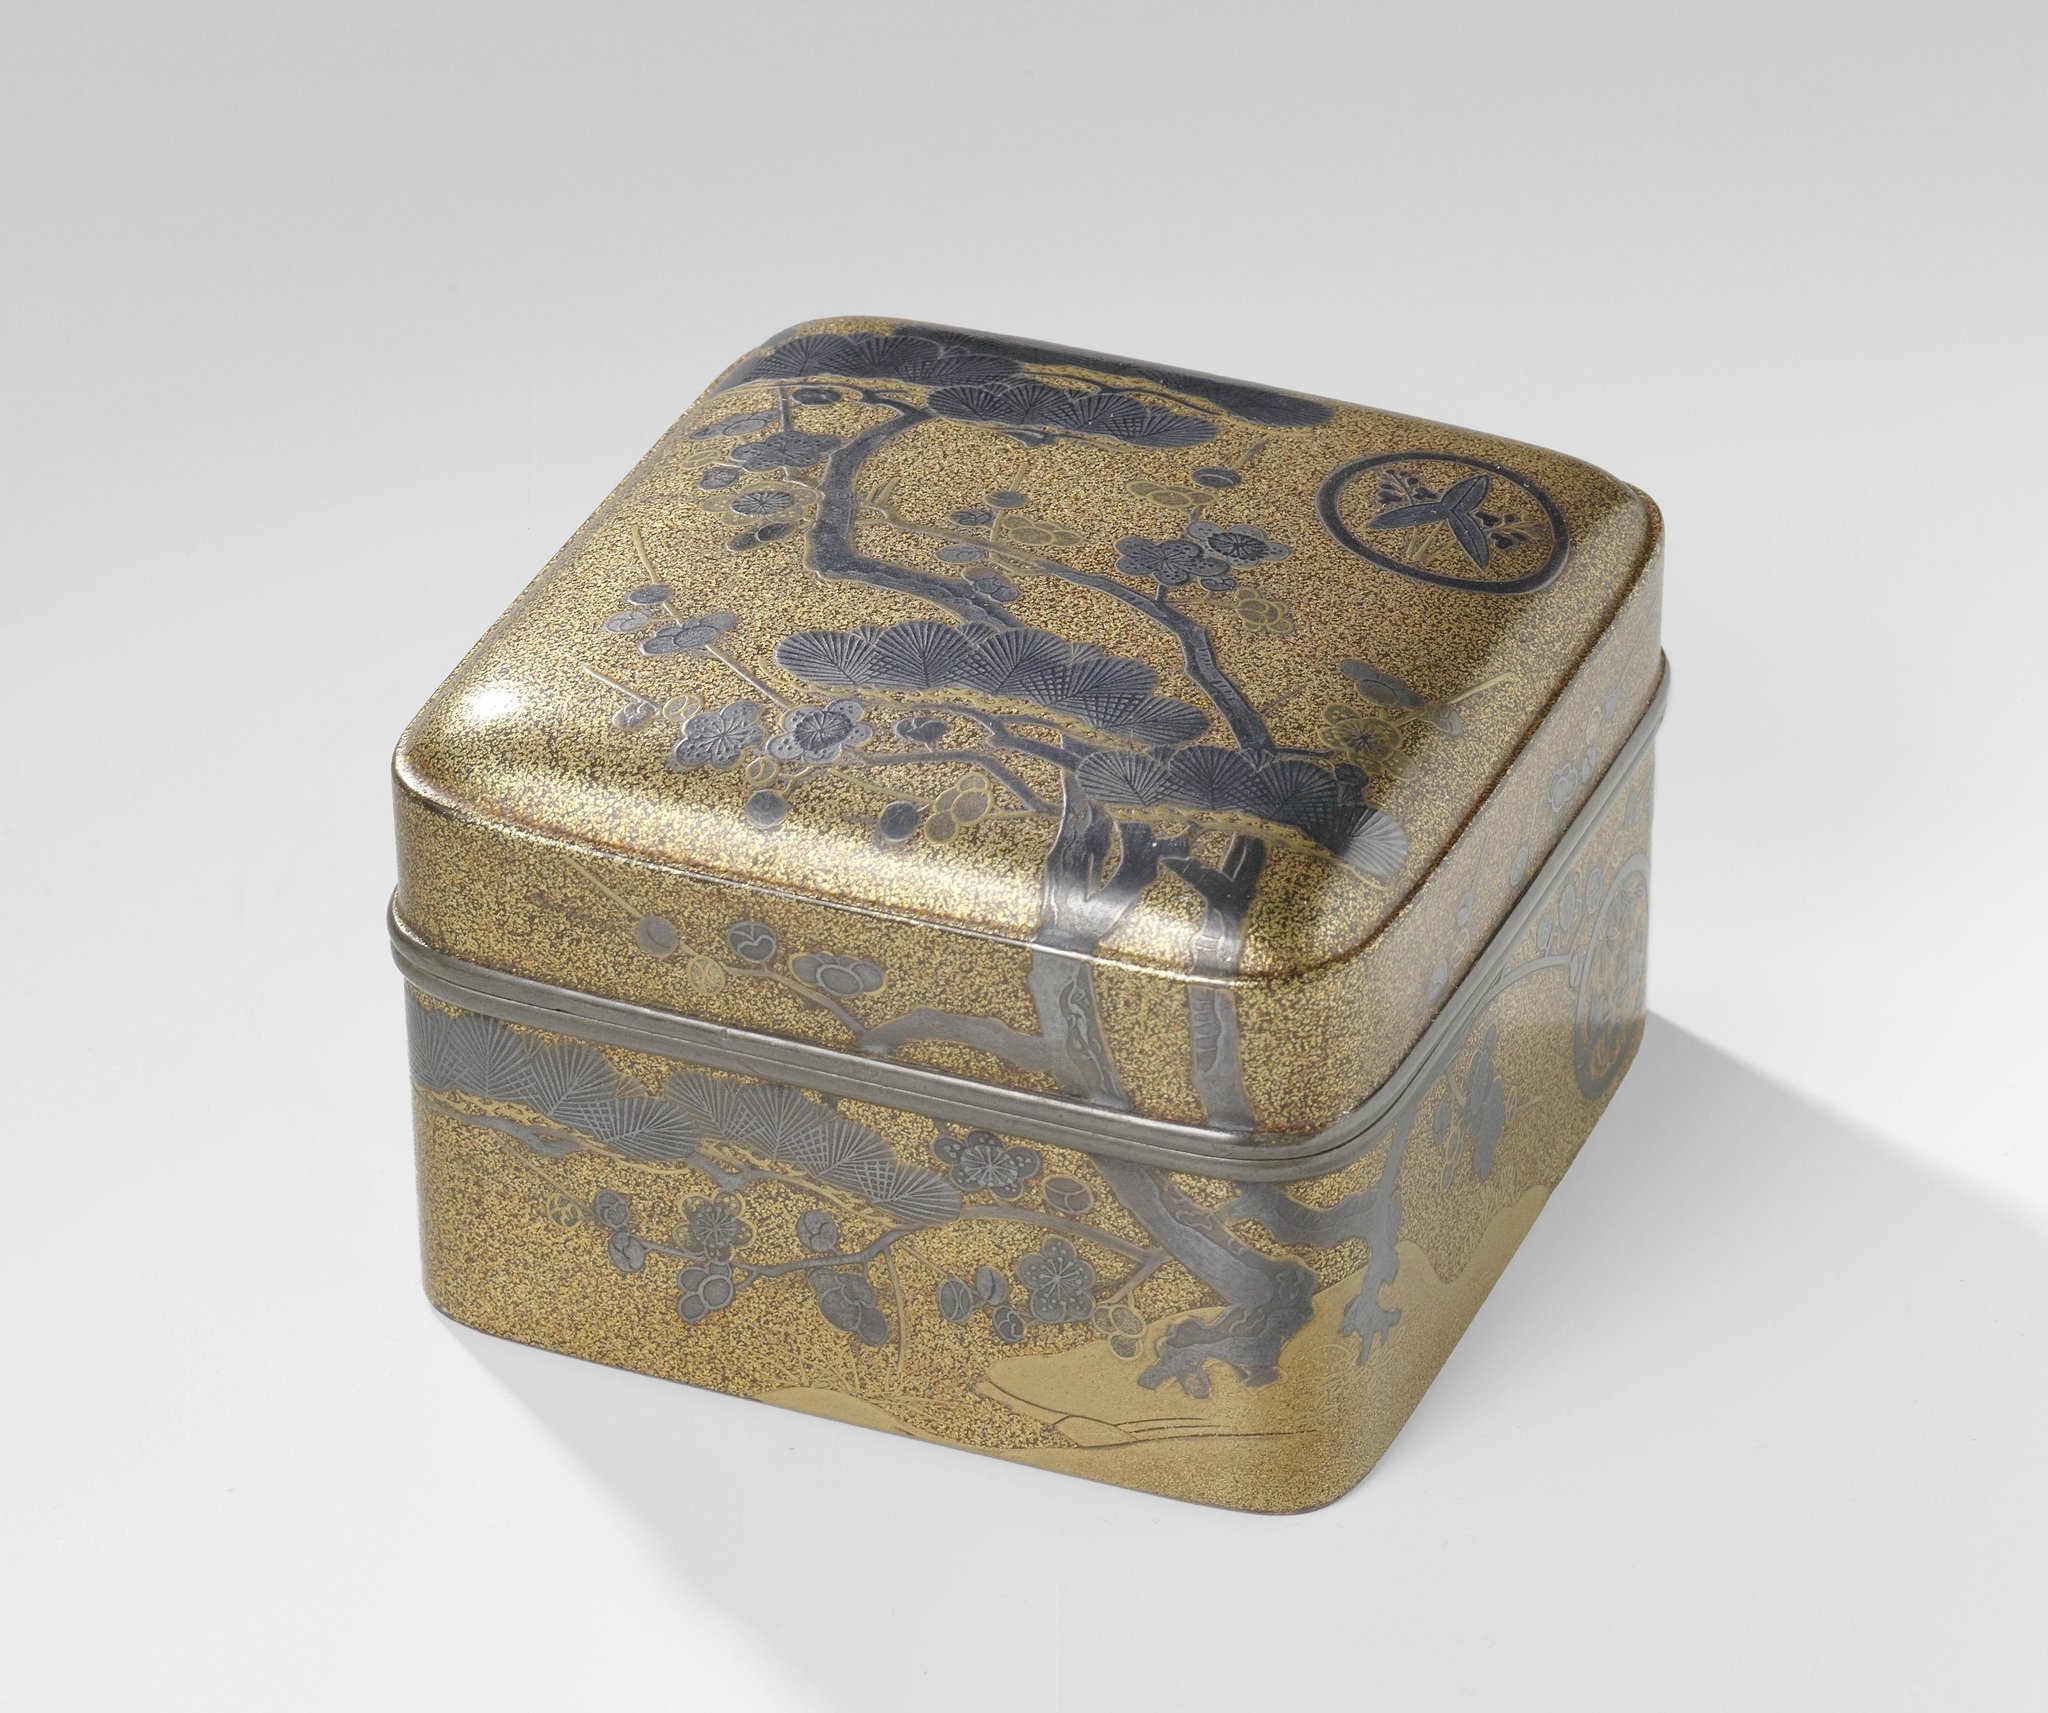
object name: kobako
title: Wierookdoos versierd met pijnbomen en pruimenbomen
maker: Anonymous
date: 1700-1800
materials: lacquer, tin, wood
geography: japan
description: Buitenzijde deksel en doos versierd met pijn- en pruimenbomen in zilver en goud op een gouden fond.